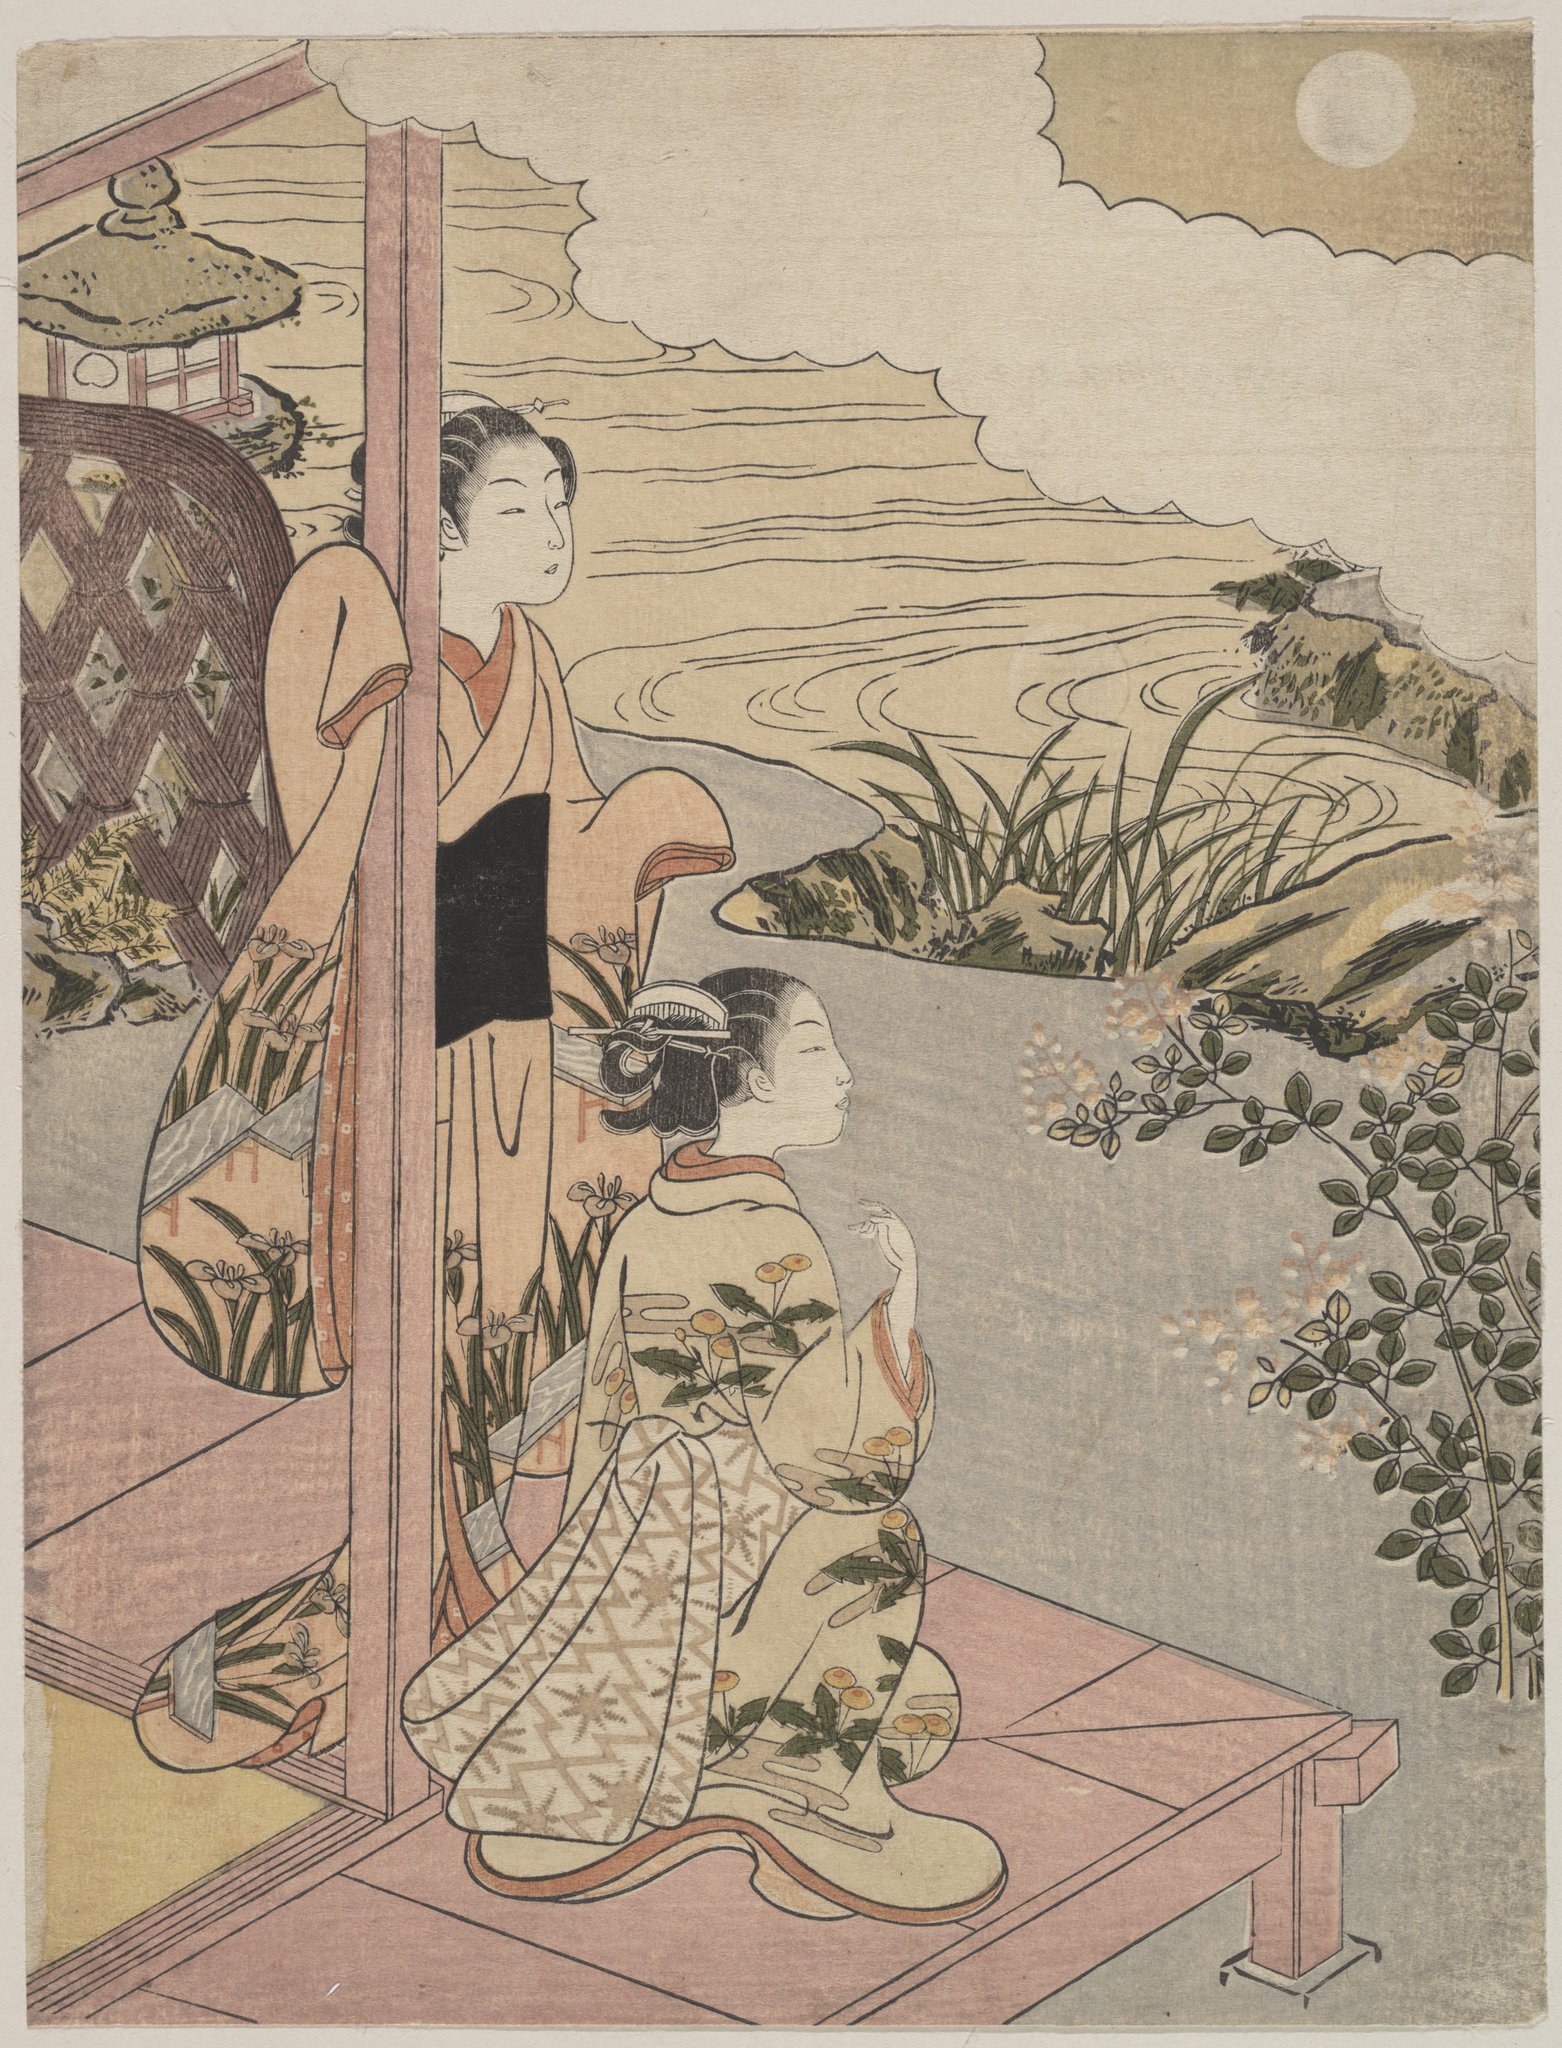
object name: print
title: Two Girls on a Veranda beside a Stream with the Moon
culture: japanese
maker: suzuki harunobu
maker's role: artist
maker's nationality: japanese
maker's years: 1725-1770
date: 1725-1770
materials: ink, paper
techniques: woodblock print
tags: girls,moon